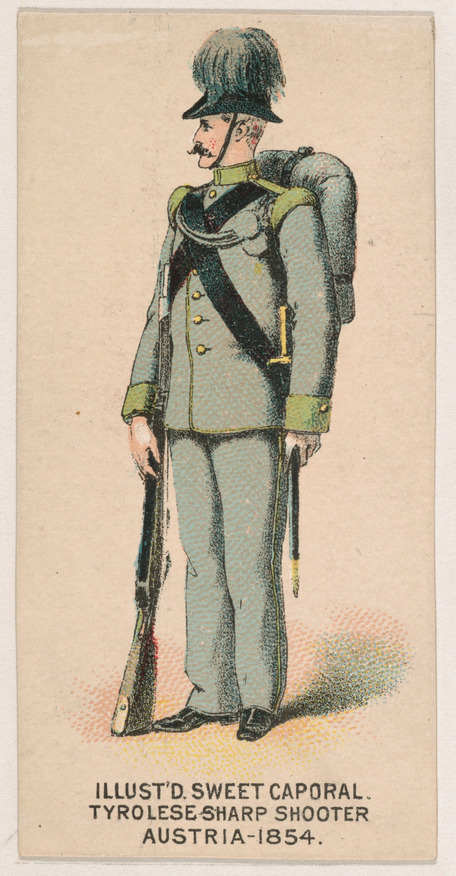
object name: print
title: Tyrolese Sharp Shooter, Austria, 1854, from the Military Series (N224) issued by Kinney Tobacco Company to promote Sweet Caporal Cigarettes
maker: kinney brothers tobacco company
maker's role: publisher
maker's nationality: american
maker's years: 1869-2011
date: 1888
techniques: color lithograph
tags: military,firearms,men,profiles